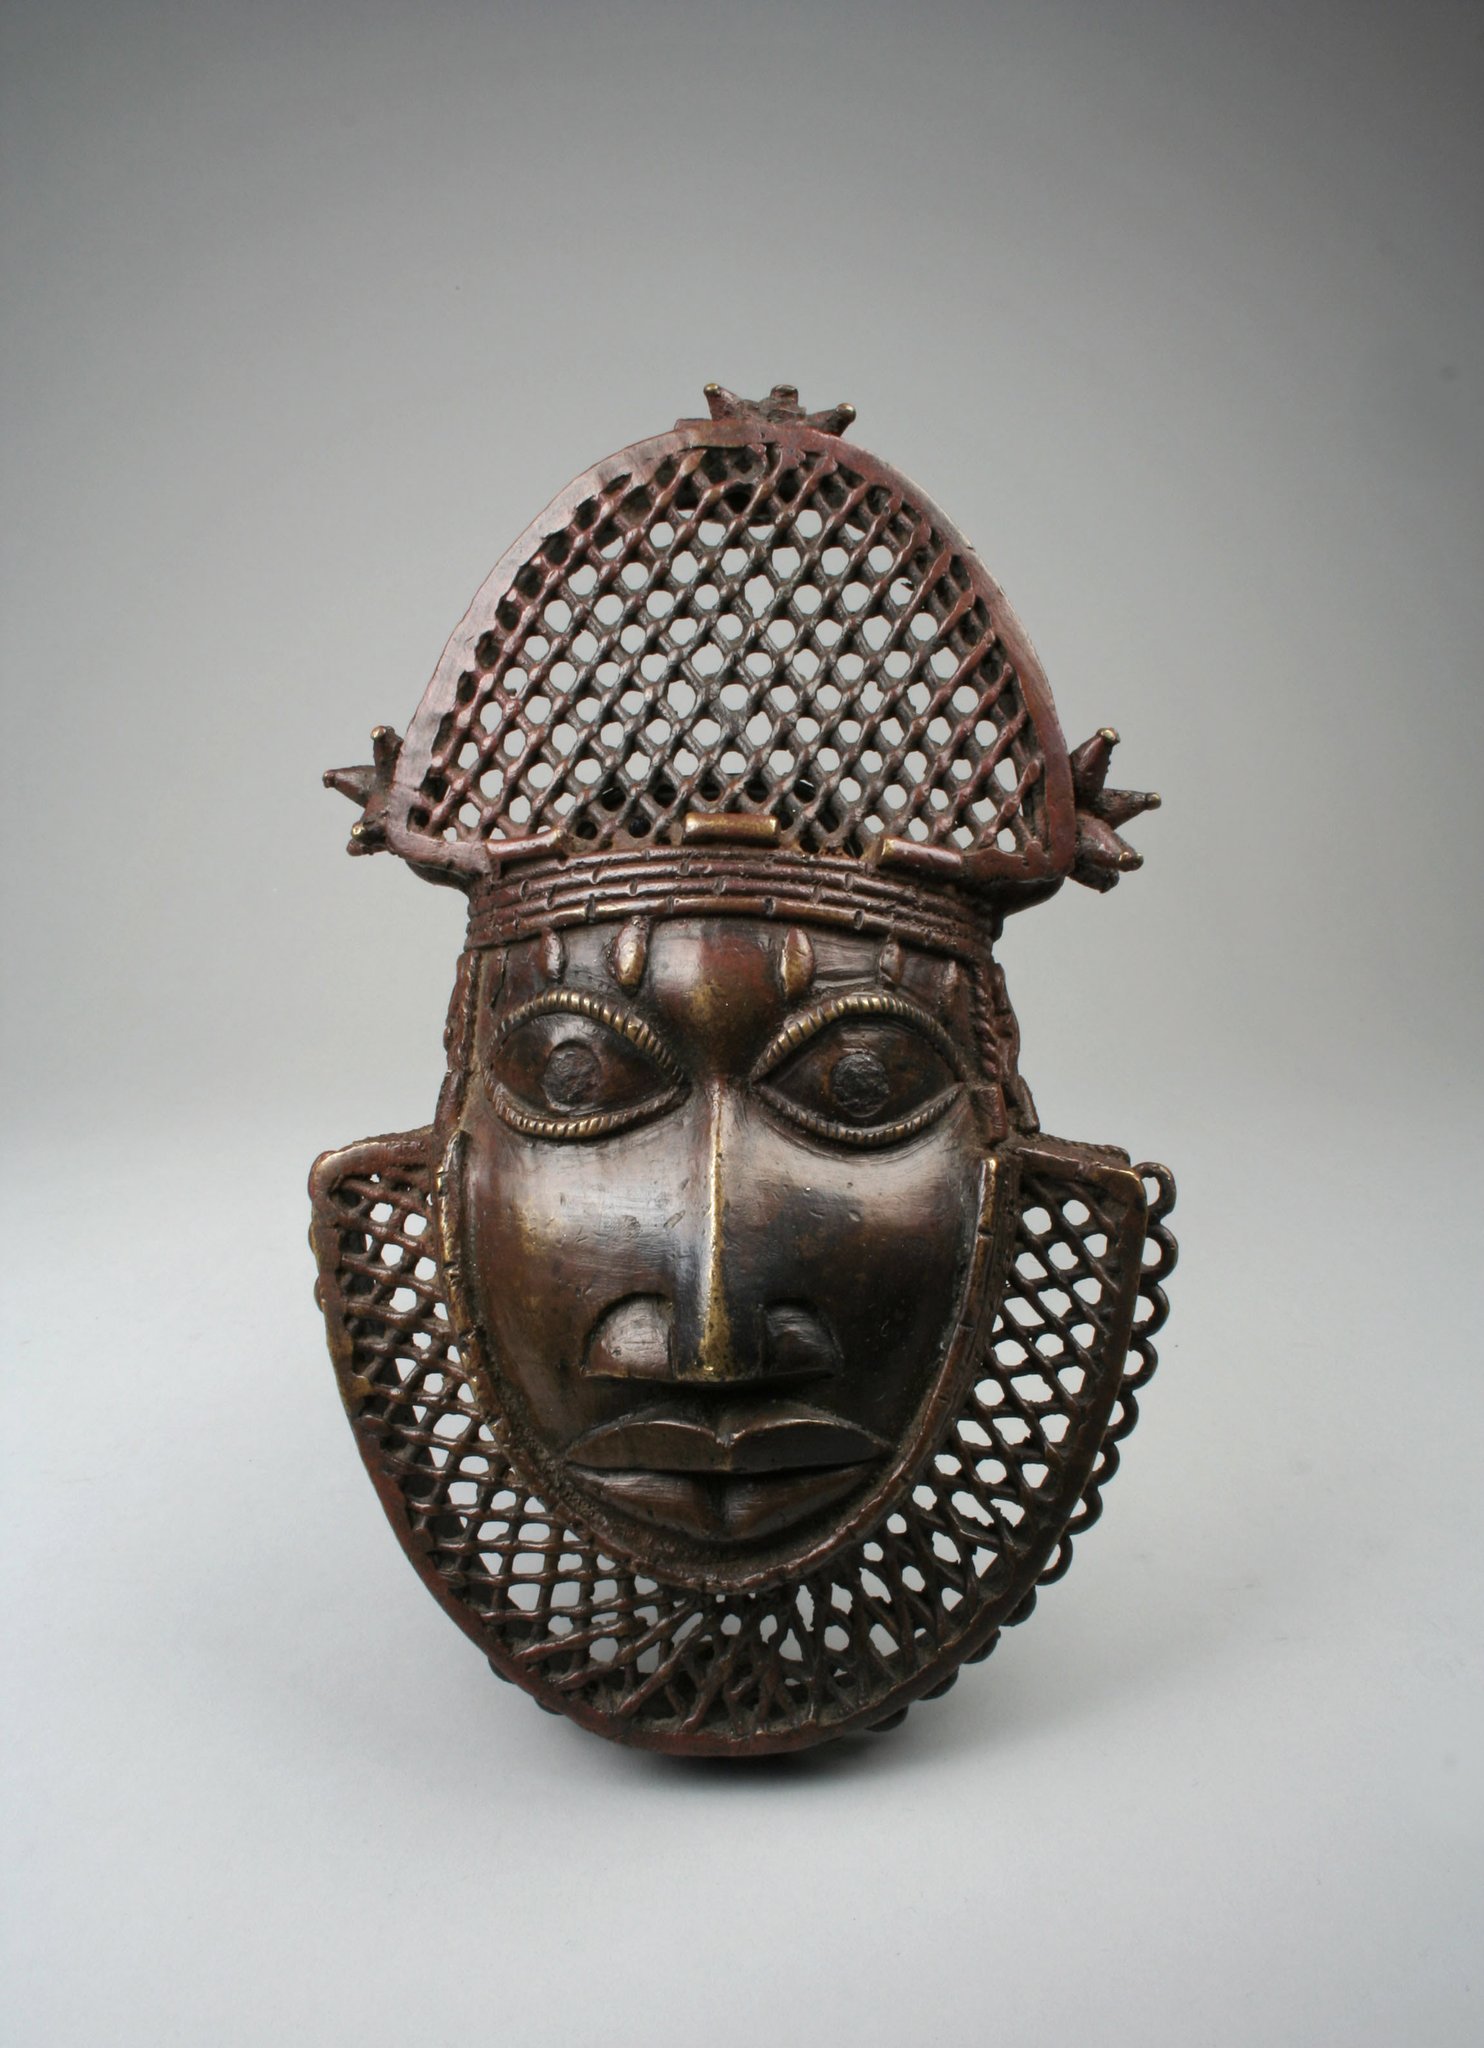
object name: hip ornament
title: Hip Ornament: Face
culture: edo period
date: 1501-1900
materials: brass, iron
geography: nigeria